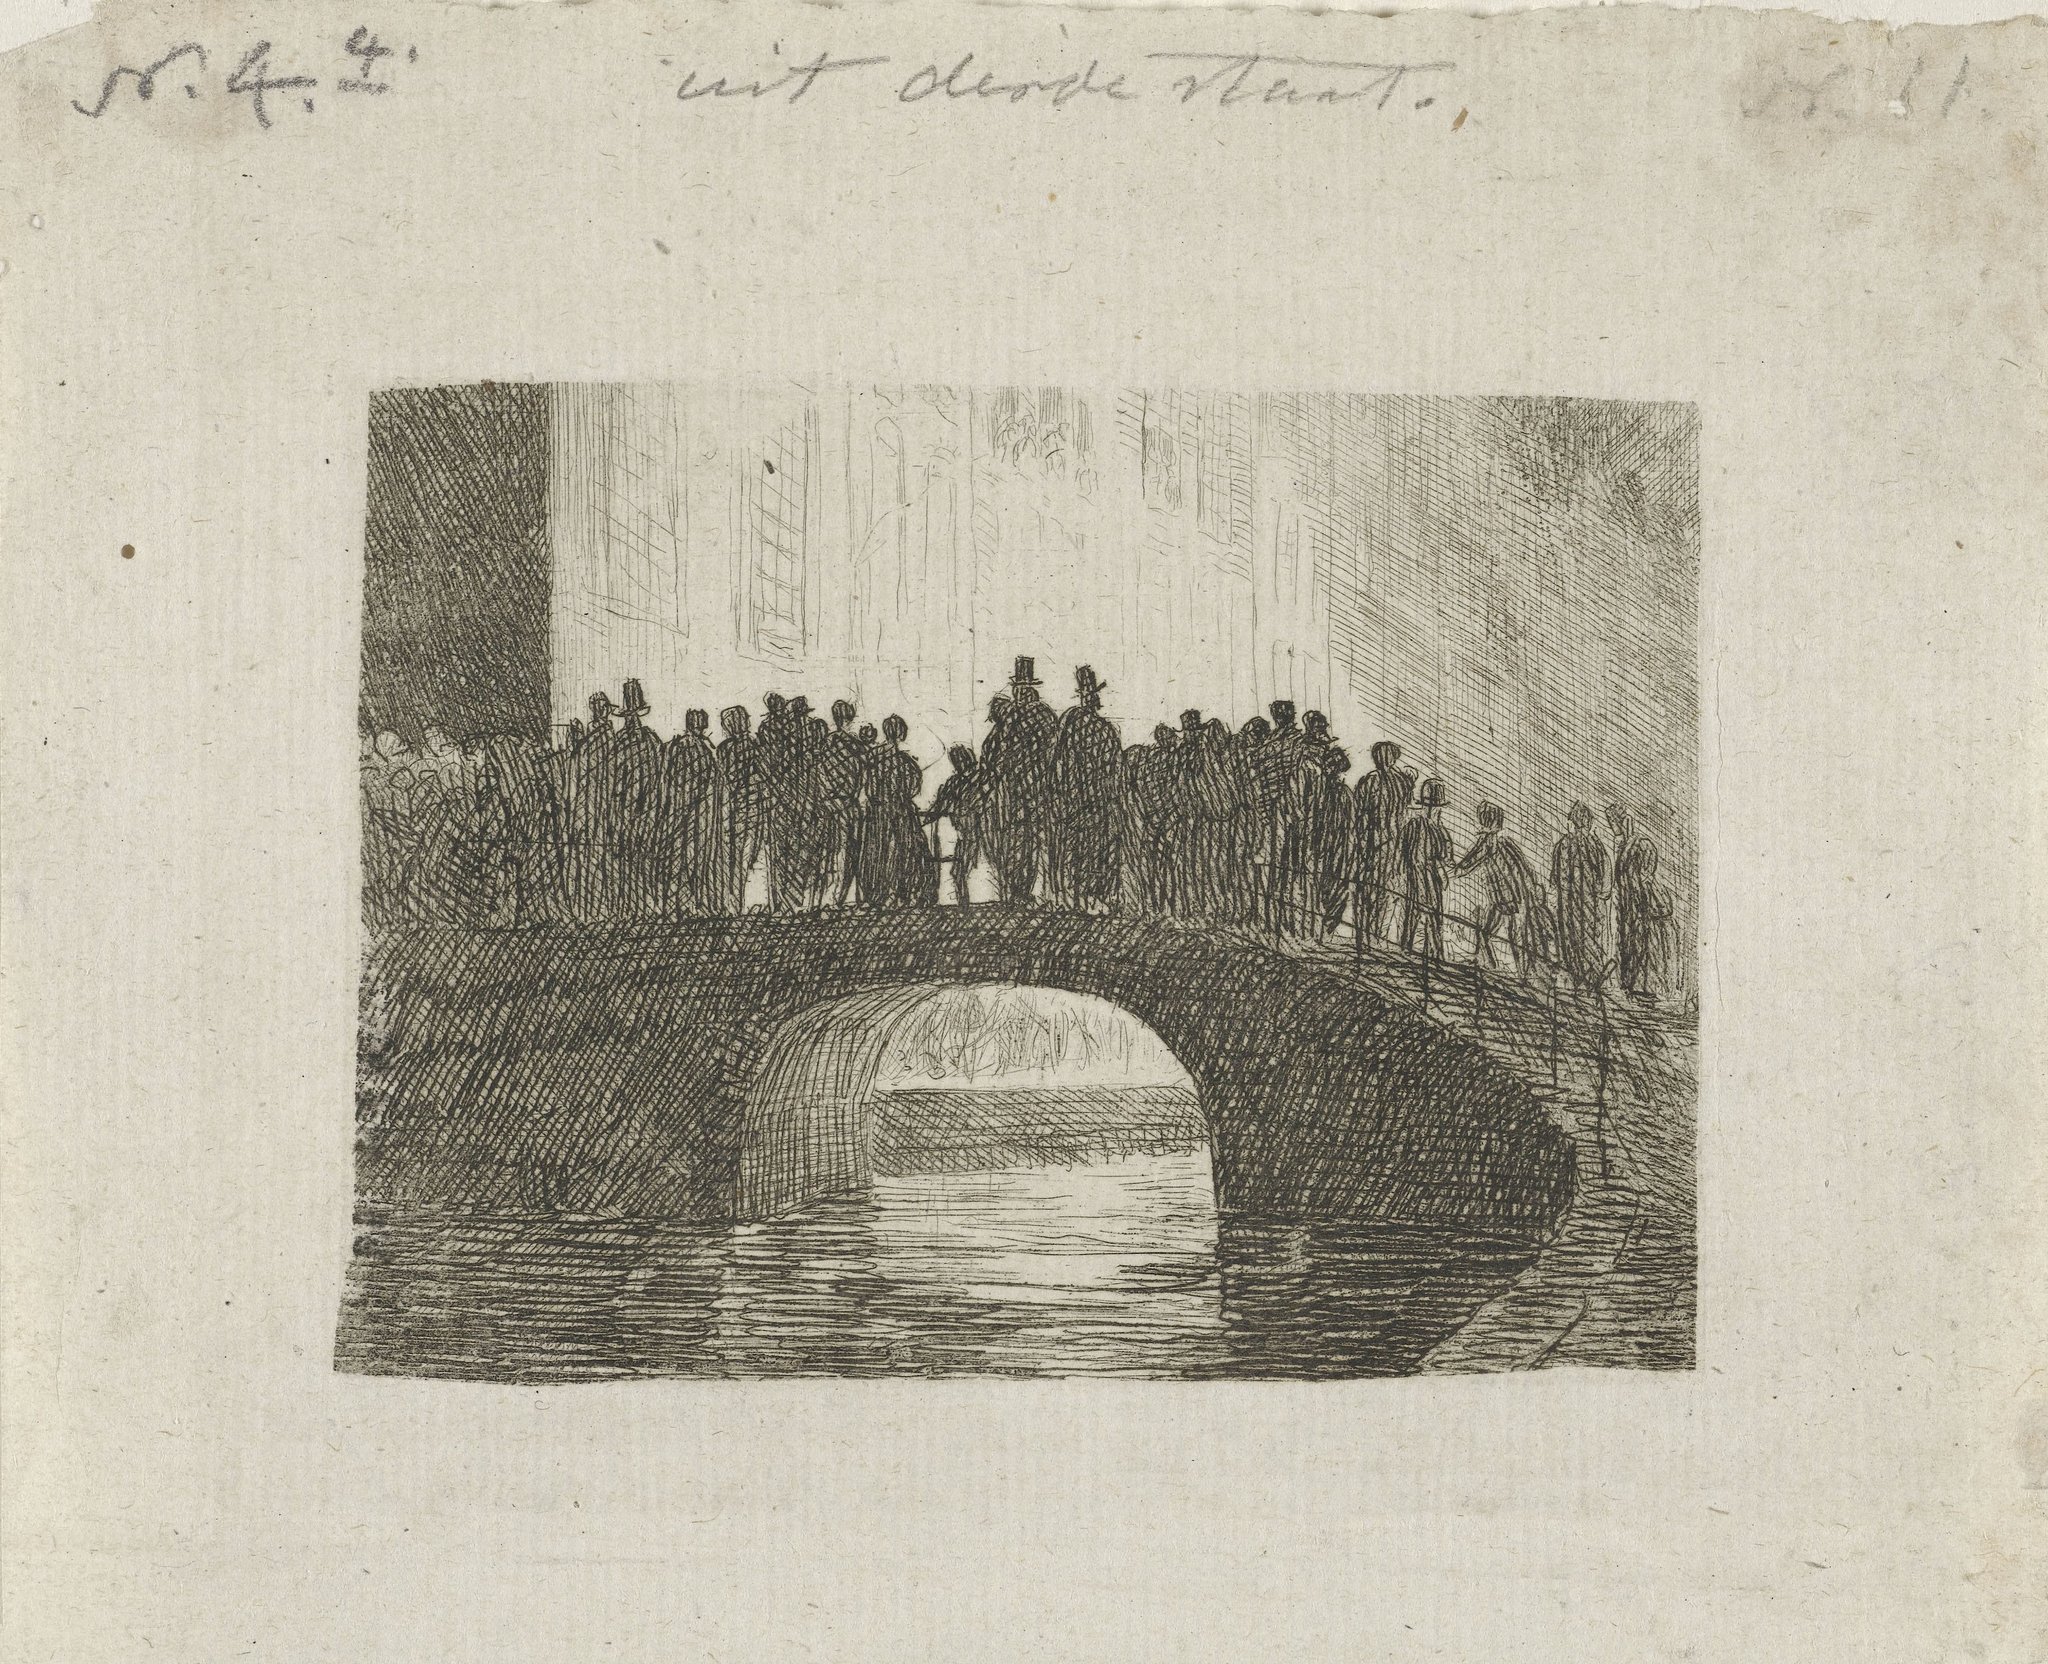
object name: print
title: Serenade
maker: cornelis van der griendt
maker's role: draughtsman, painter, print maker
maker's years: 1827-1918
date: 1852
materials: paper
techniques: etching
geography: netherlands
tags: city-view in general; 'veduta' - ii - ideal city (+ city(-scape) with figures, staffage)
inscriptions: collector's mark: Lugt 2228